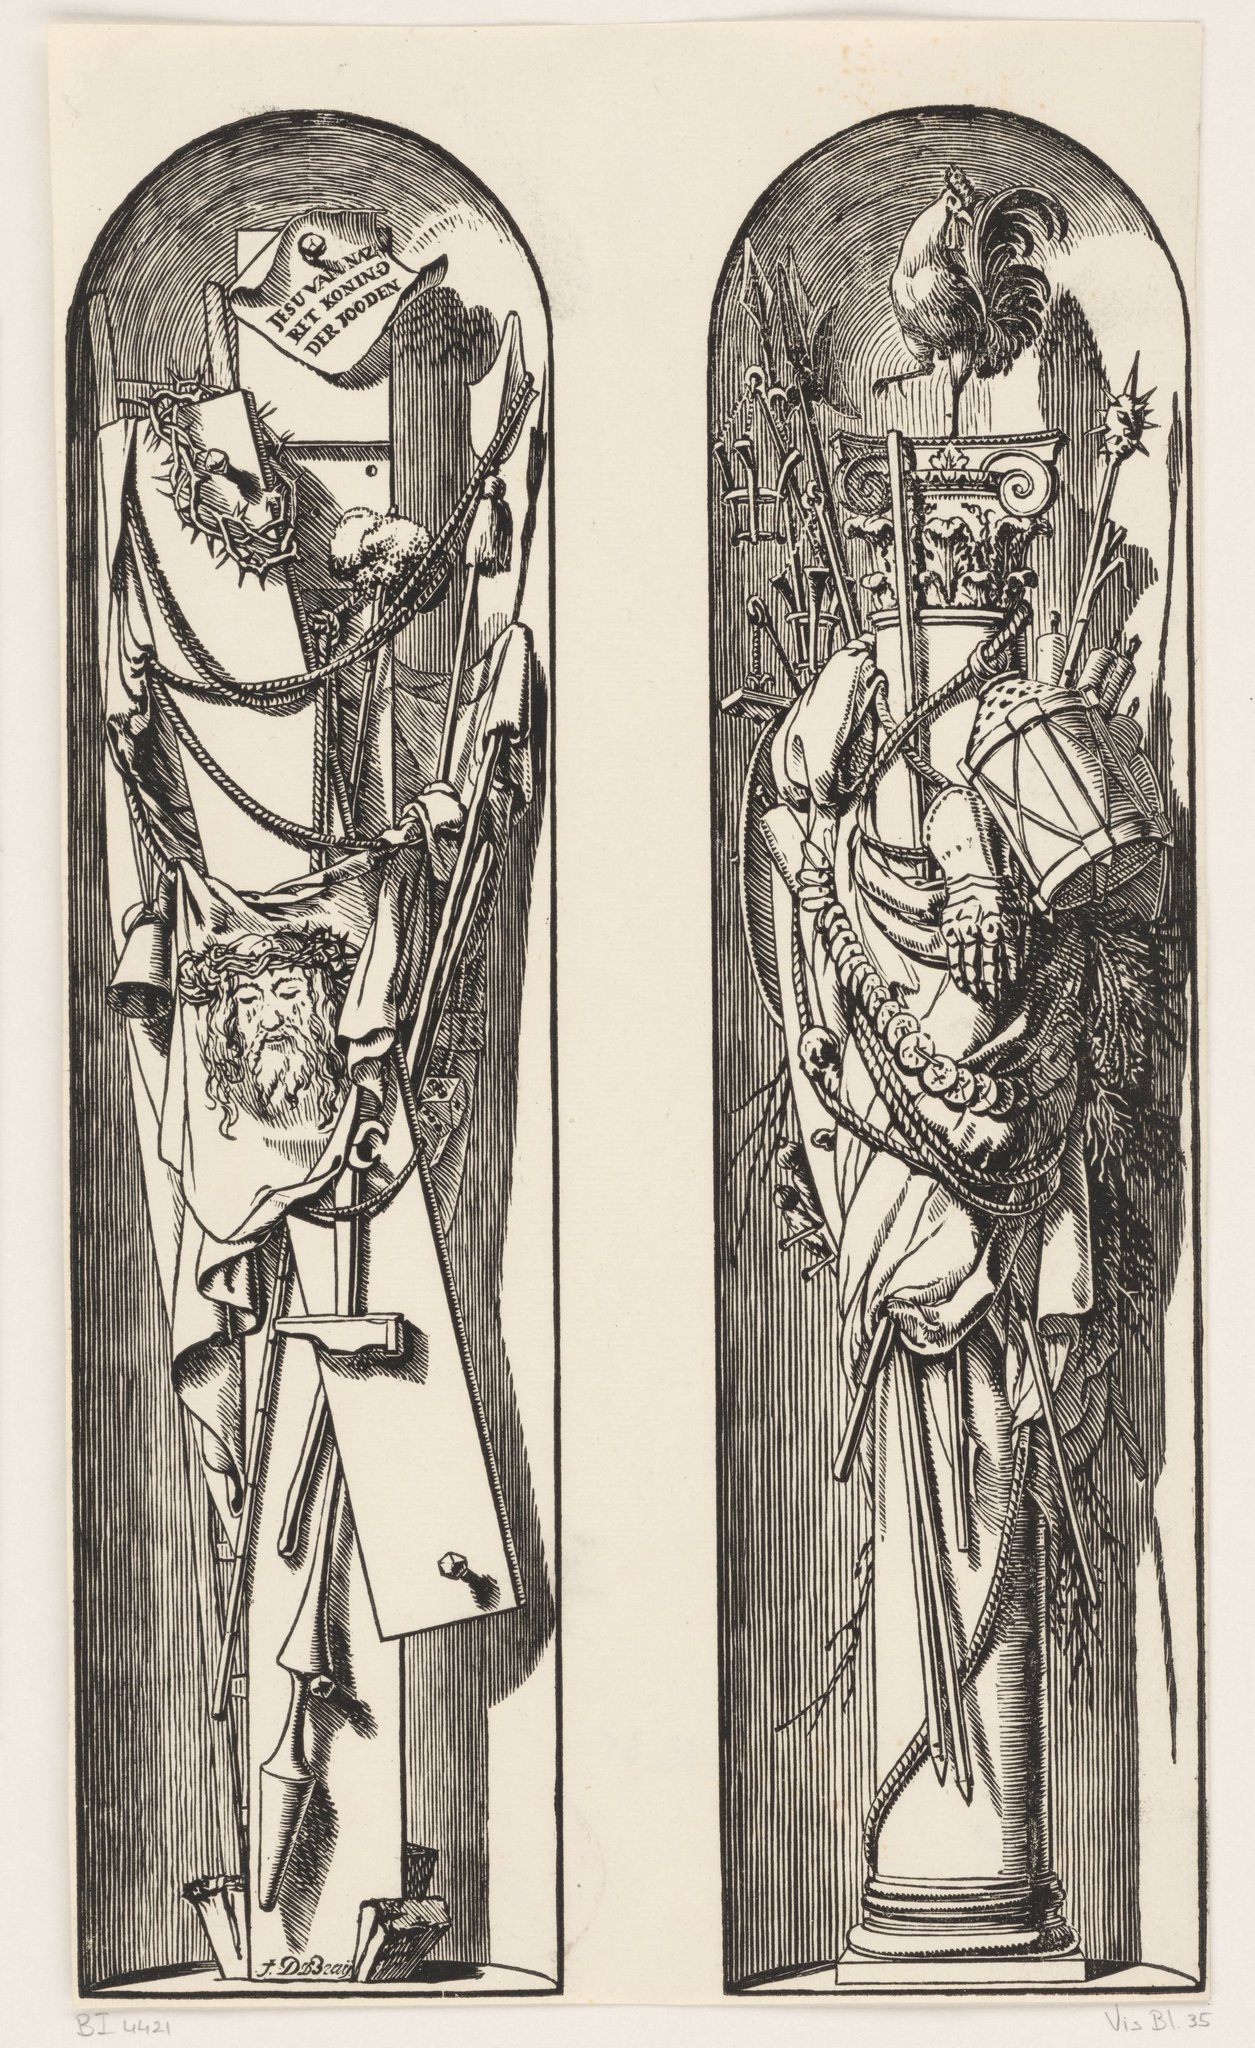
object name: print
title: Lijdenswerktuigen van Christus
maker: dirck de bray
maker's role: draughtsman, painter, print maker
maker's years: 1625-1694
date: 1677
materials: paper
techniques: woodcut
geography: netherlands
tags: lance ~ instruments of the passion, single instruments of the passion, crown of thorns ~ instruments of the passion, nails ~ instruments of the passion, cross ~ instruments of the passion, cock on column ~ instruments of the passion, 'vera icon', 'sudarium', veronica-portrait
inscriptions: collector's mark: Lugt 240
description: De staander en dwarsbalk van Christus' kruis met andere attributen van zijn lijden, waaronder de doornenkroon, de hamer waarmee hij aan het kruis is genageld, de spons met azijn, de lans, dobbelstenen en de zweetdoek van Veronica.